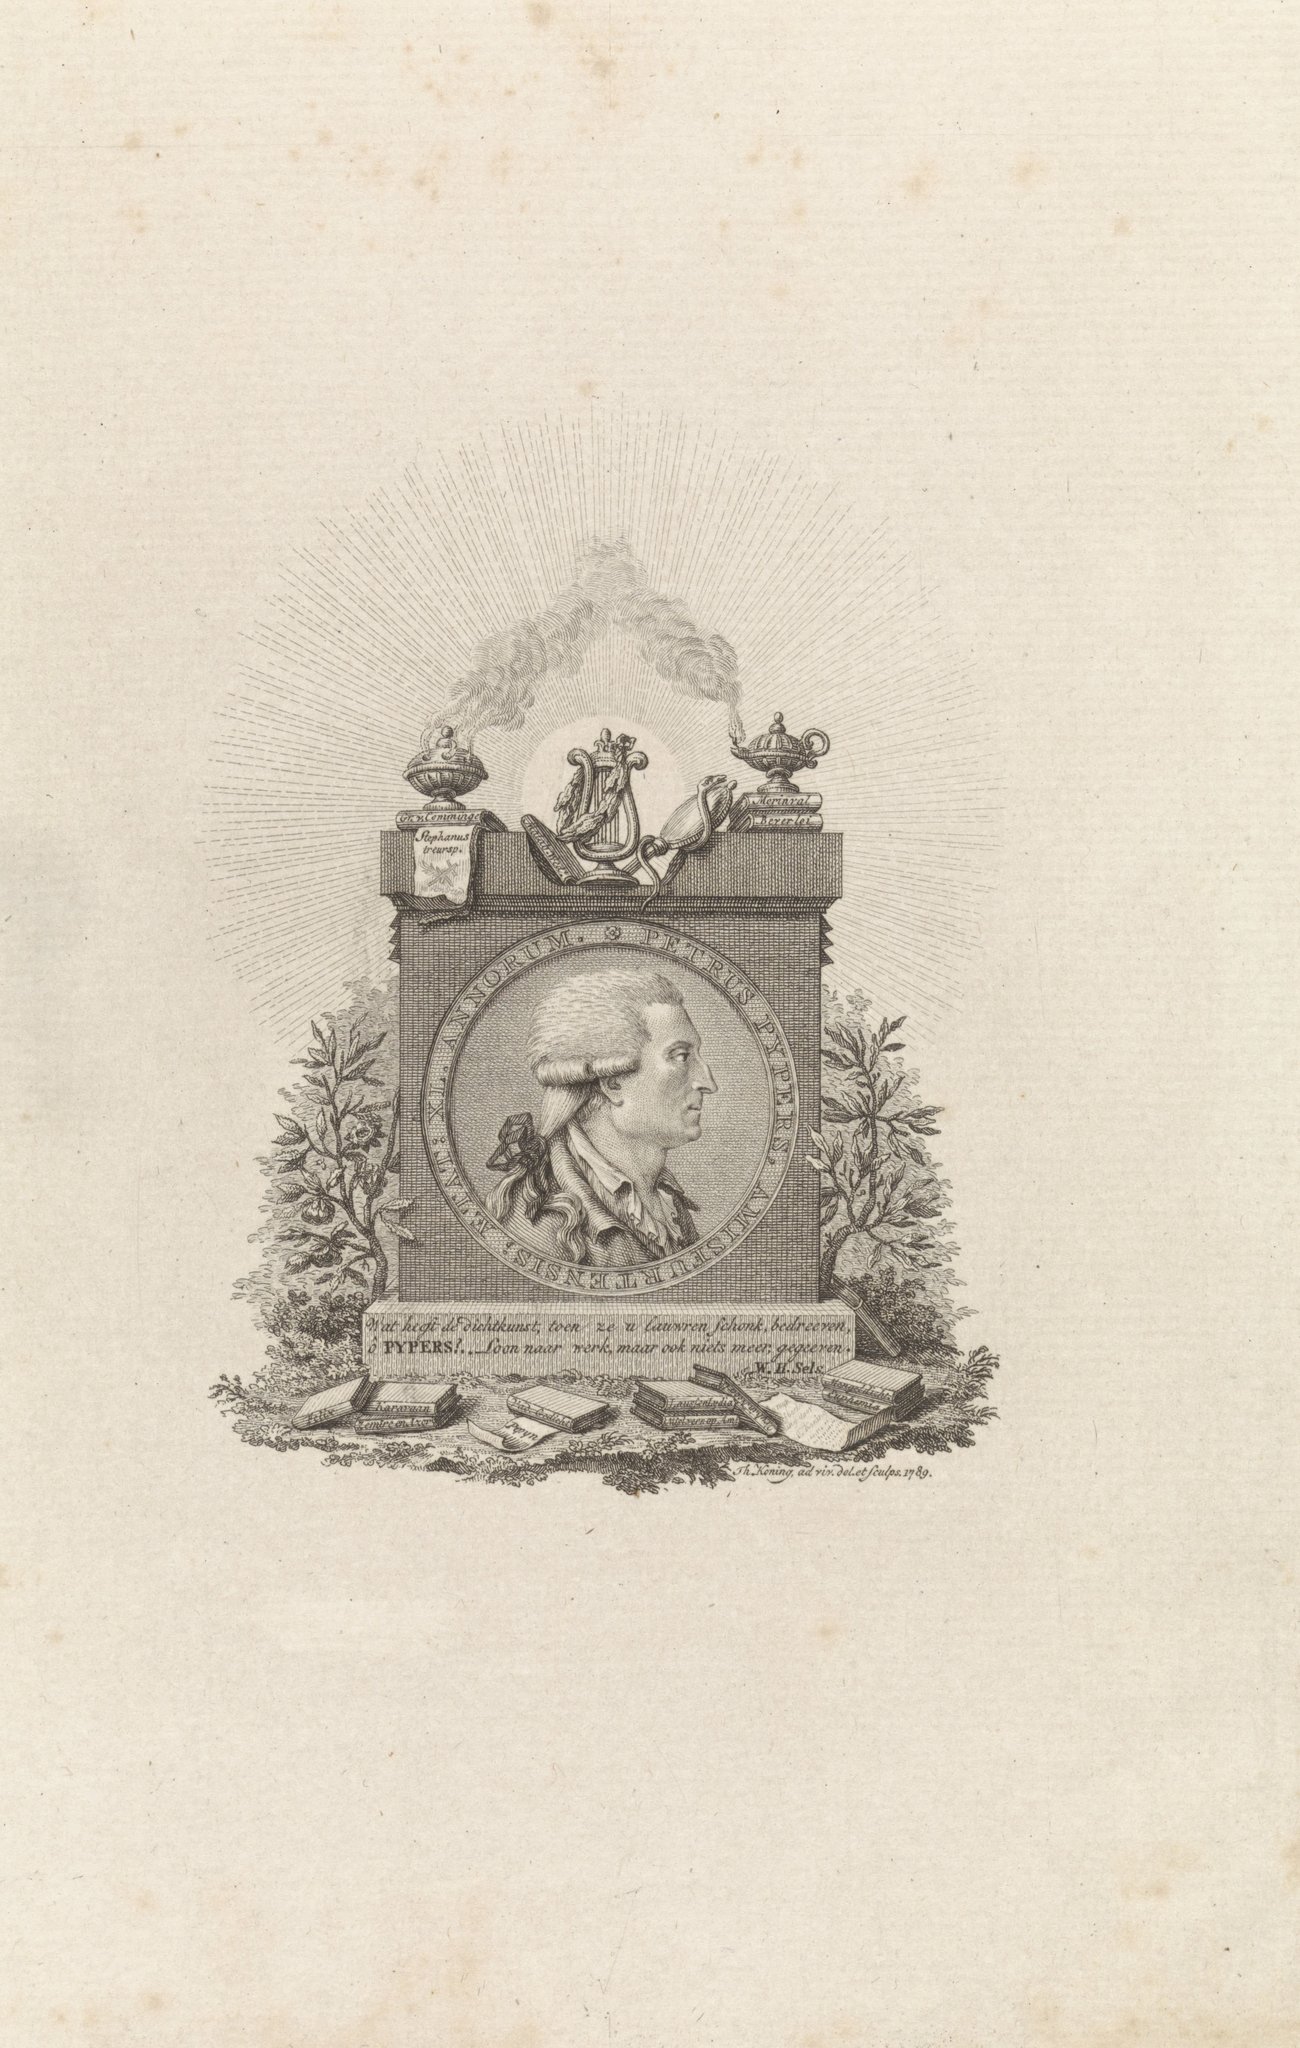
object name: print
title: Gedenkteken voor Petrus Pijpers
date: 1789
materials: paper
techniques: engraving, etching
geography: amsterdam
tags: other memorial structures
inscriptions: collector's mark: Lugt 2228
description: Allegorisch gedenkteken voor de dichter Petrus Pijpers. In het midden het monument met daarop het portret van Pijpers, in een cirkelvormige omlijsting. Op het monument twee wierookvaten, een harp met een lauwerkrans, een slang en een aantal boeken. Voor het monument liggen eveneens boeken. Onder het portret een tweeregelig vers.